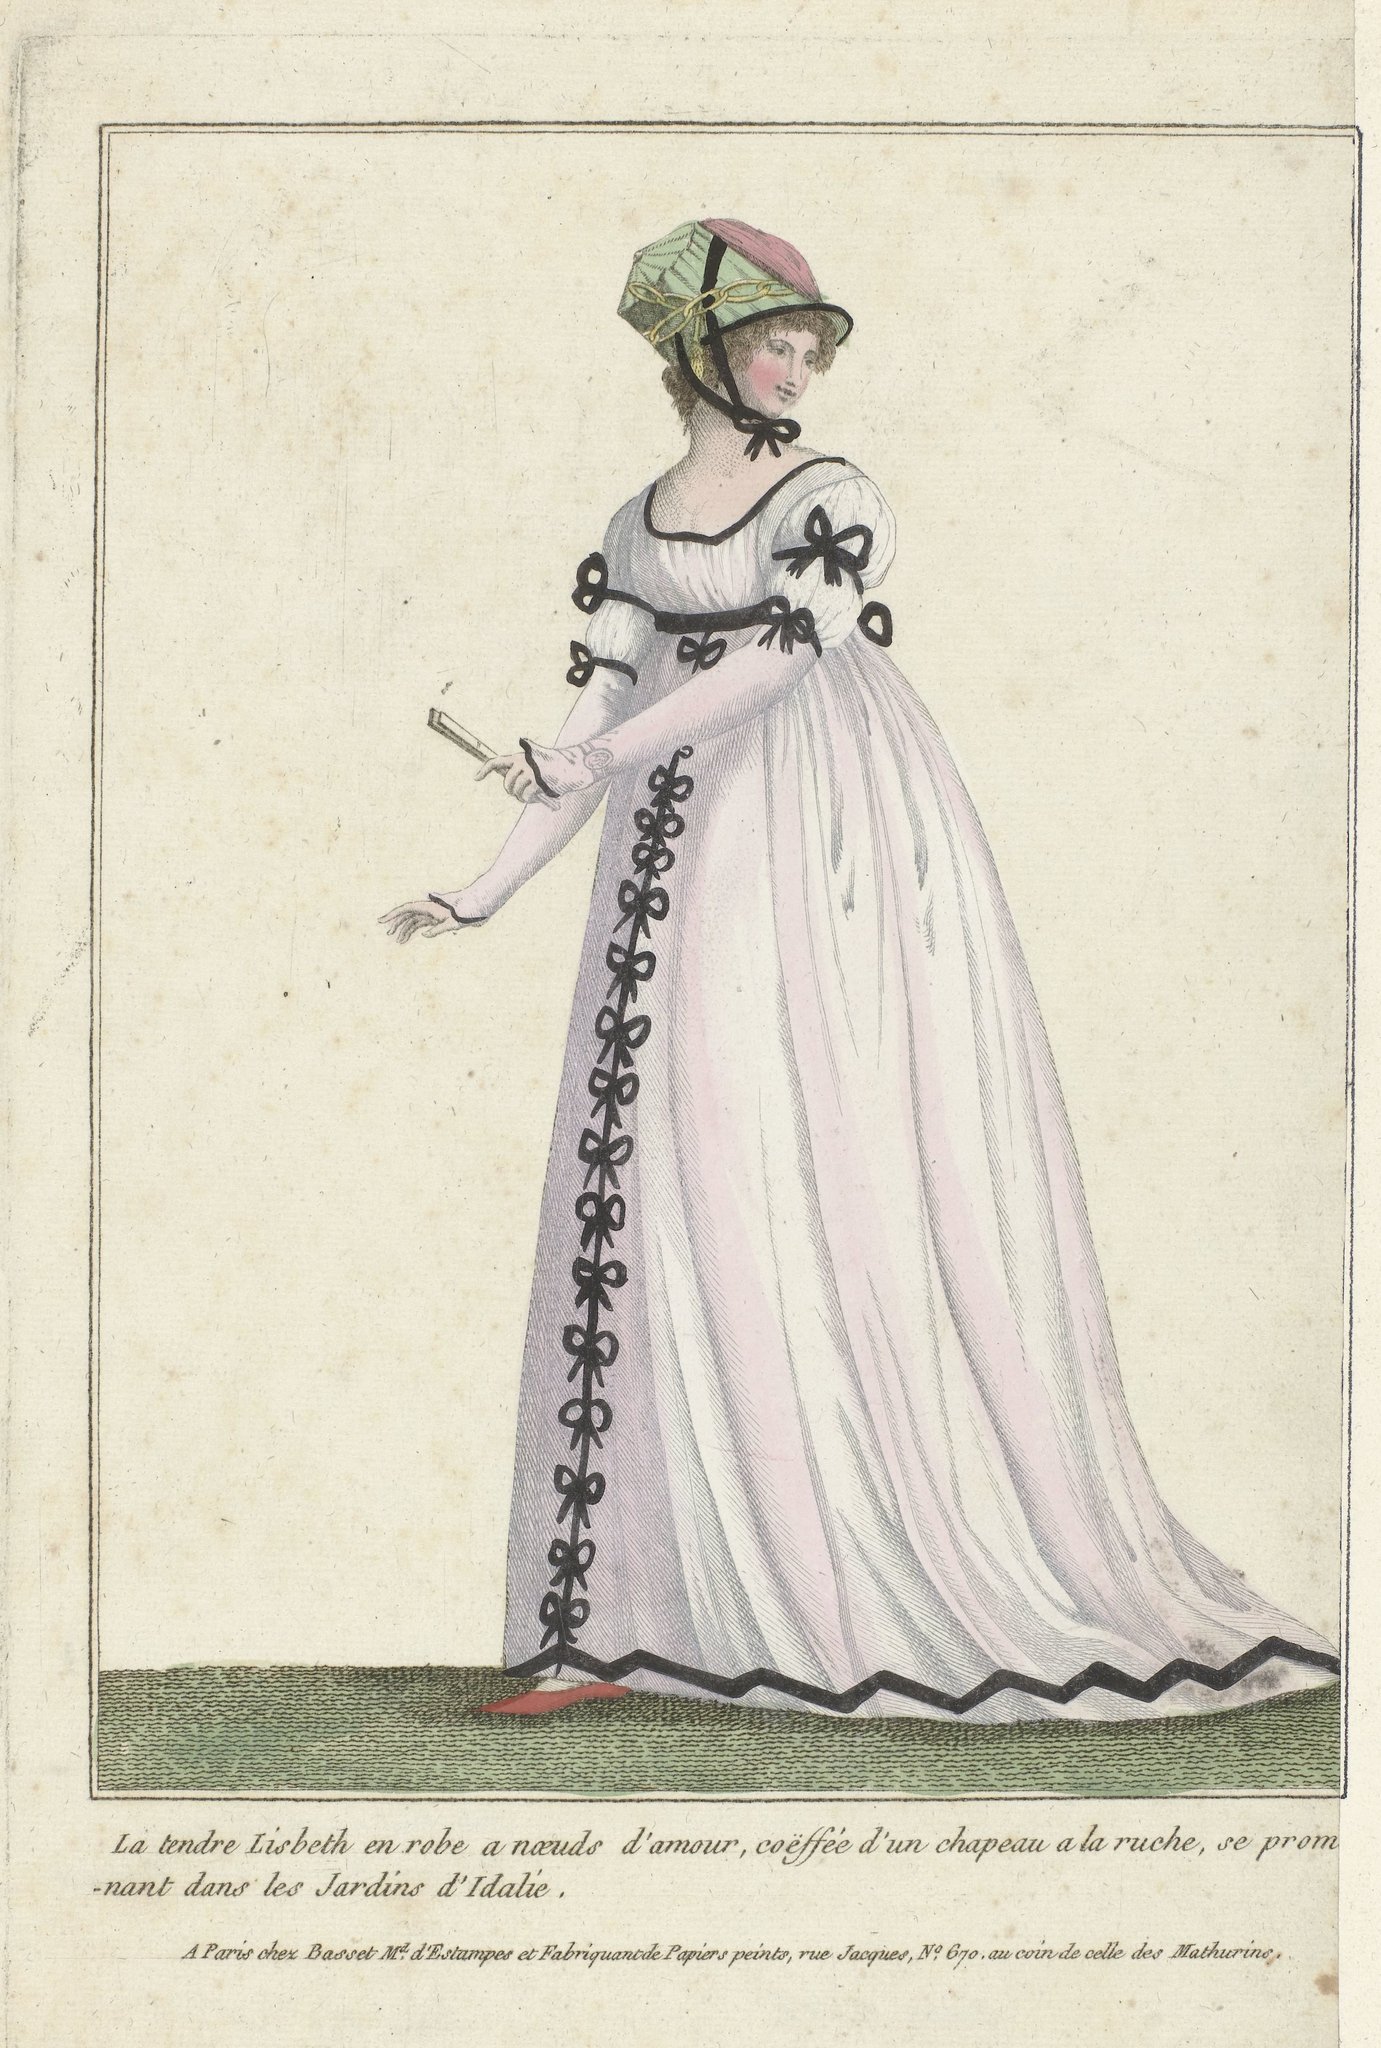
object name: fashion print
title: Collection consacrée aux modes d'hommes et de femmes, 1783-1813: La tendre Lisbeth (...)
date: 1783-1813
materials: paper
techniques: engraving, hand coloring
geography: paris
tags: bow (ornamental part of clothing) (+ women's clothes), fashion plates, head-gear: hat (+ women's clothes), dress, gown (+ women's clothes), fan (+ women's clothes), bracelet, wristlet (+ women's clothes)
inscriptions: address: ‘A Paris chez Basset Md d'Estampes et Fabriquant de Papier en Rouleaux, Rue Jacques No.670, au coin de celle des Mathurins.’, caption: ‘La tendre Lisbeth en robe de noeuds d'amour, coëffée d'un chapeau a la ruche, se prom-nant dans les jardins d'idalie.’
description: Vrouw gekleed in een japon met strikken. Lange mouwen en sleep. Op het hoofd een 'chapeau a la ruche'.Verdere accessoires: waaier, armband om de linkerpols, platte schoen met puntige neus. Volgens het onderschrift wandelt ze door de 'Jardins d'Idalie'. De prent maakt deel uit van een reeks van ten minste 82 modeprenten, Collection consacrée aux Modes d'hommes et de femmes, uitgegeven door Basset, Parijs, tussen 1783 en 1813